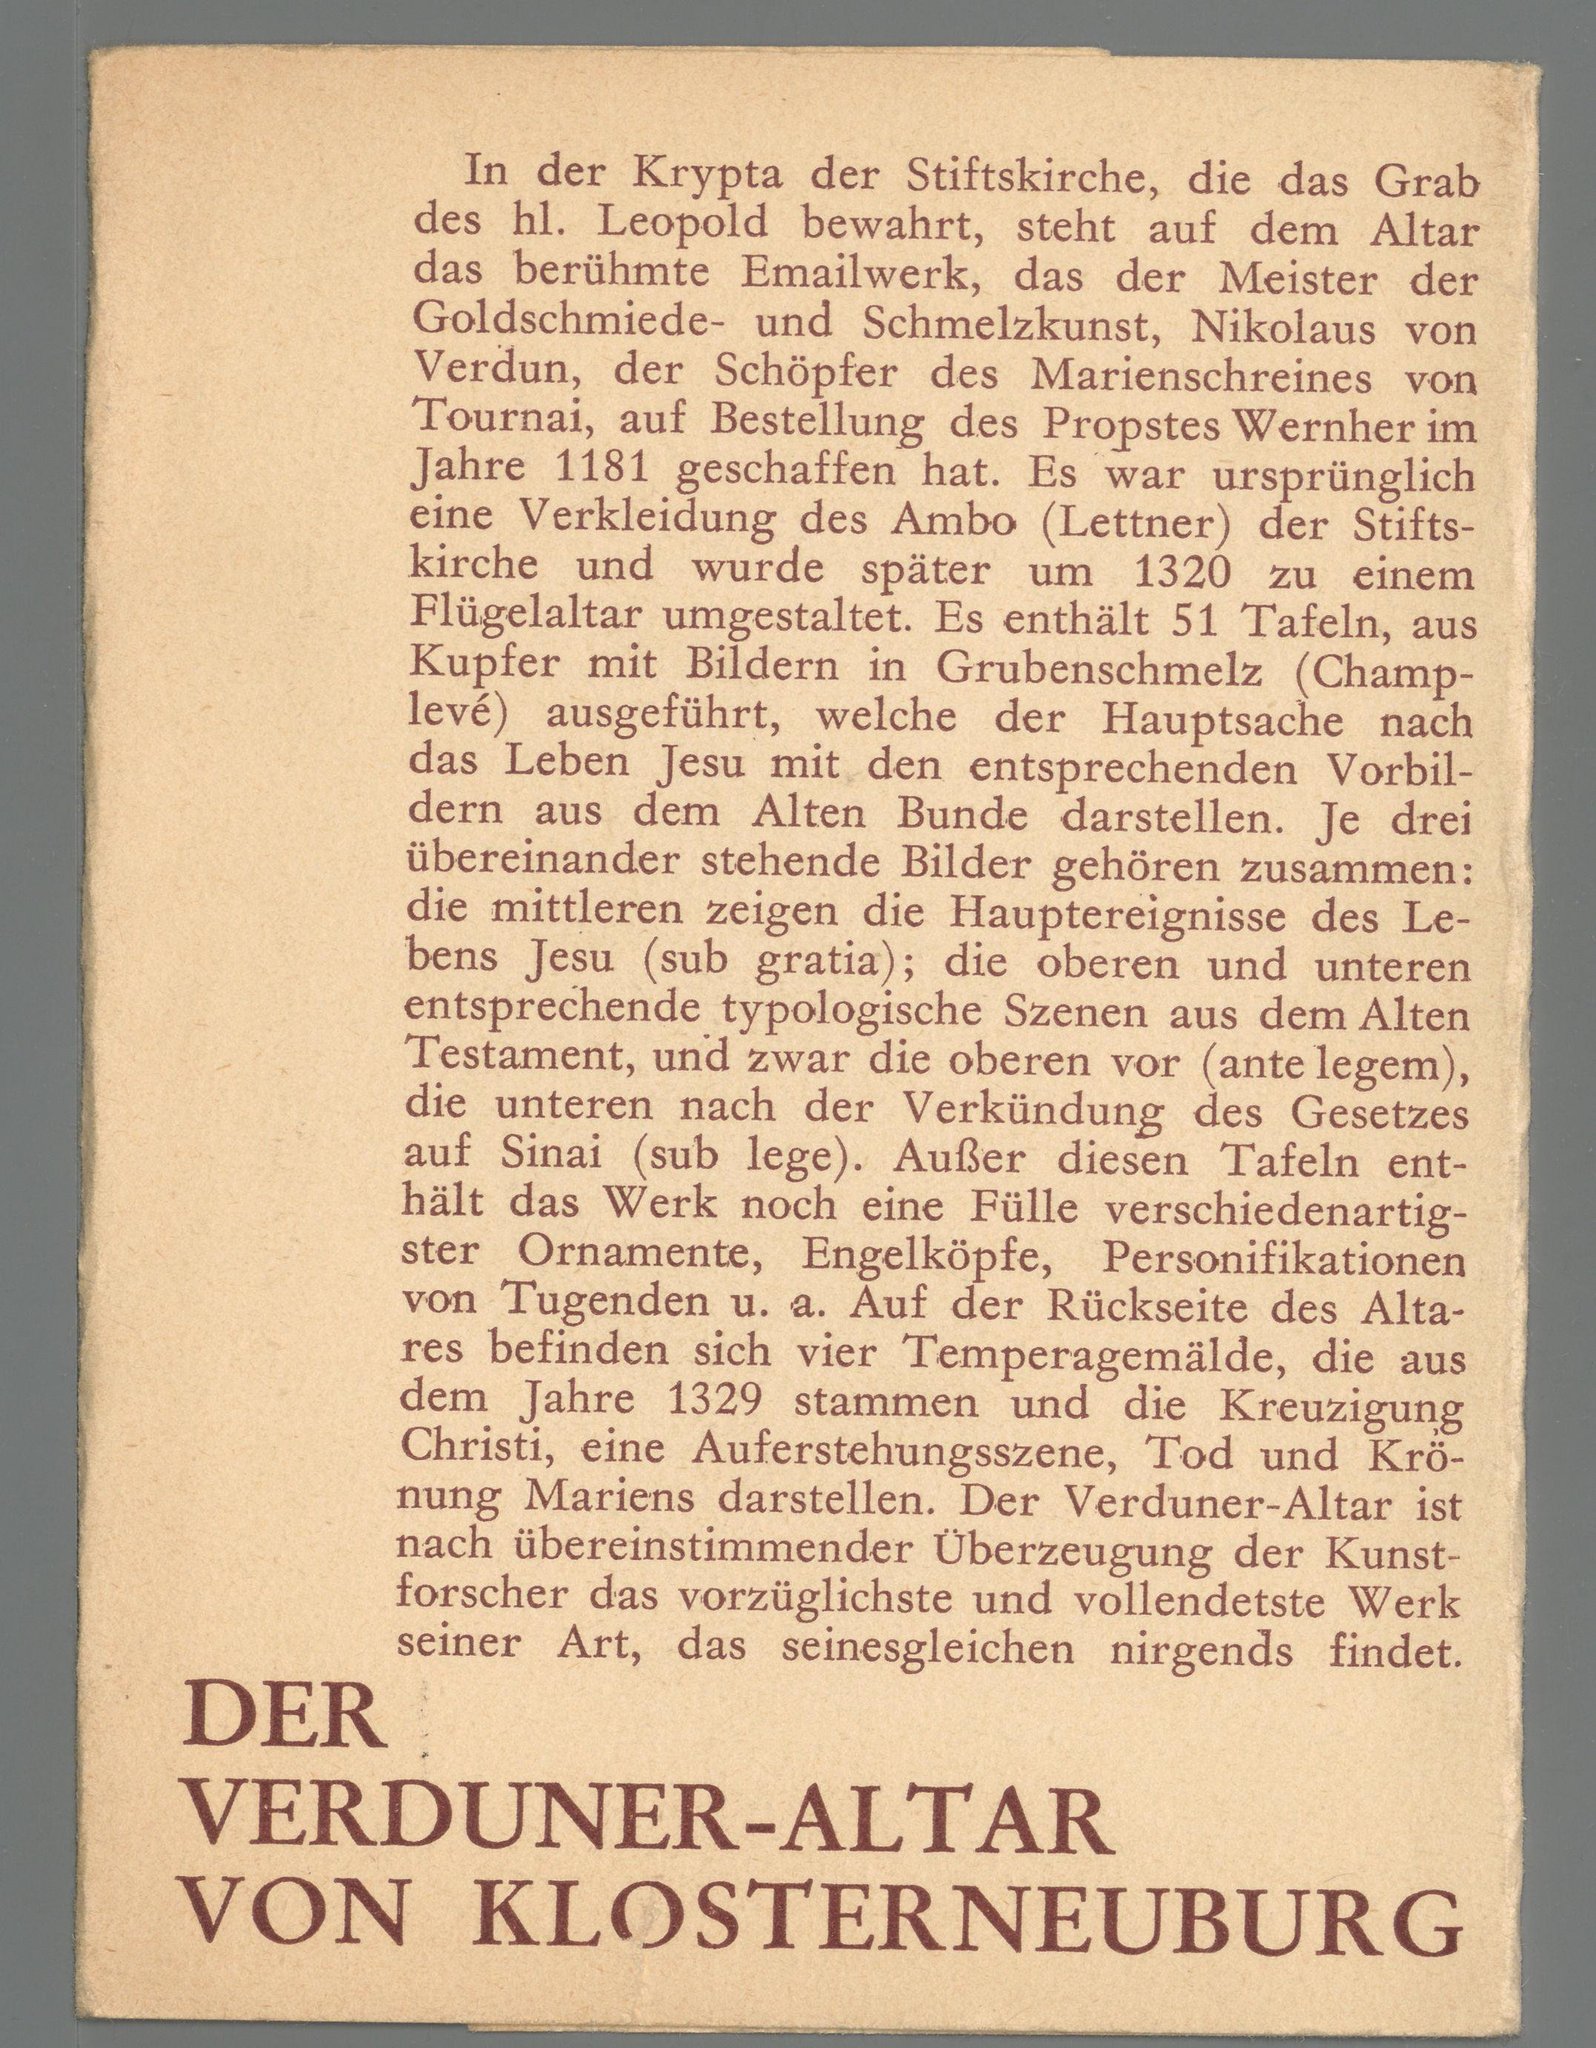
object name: wrapper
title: Der Verduner-Altar von Klosterneuburg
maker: Anonymous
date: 1927-1955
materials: paper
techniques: letterpress printing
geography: klosterneuburg